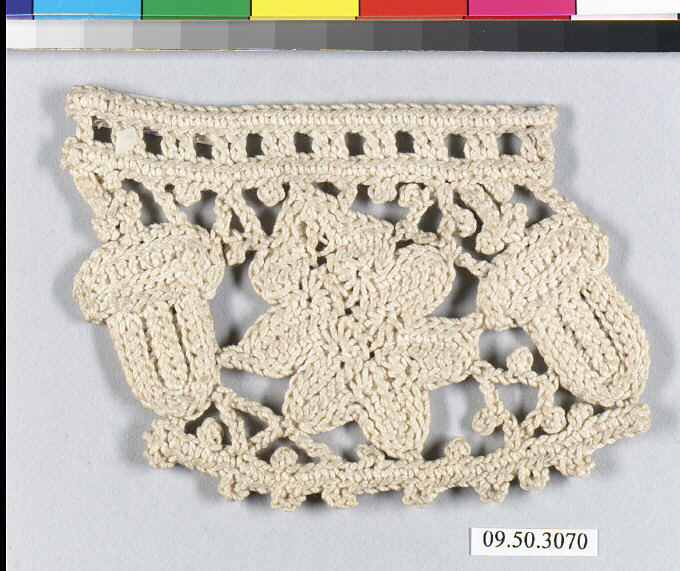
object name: sample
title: Crochet Work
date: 1801-1900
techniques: crochet